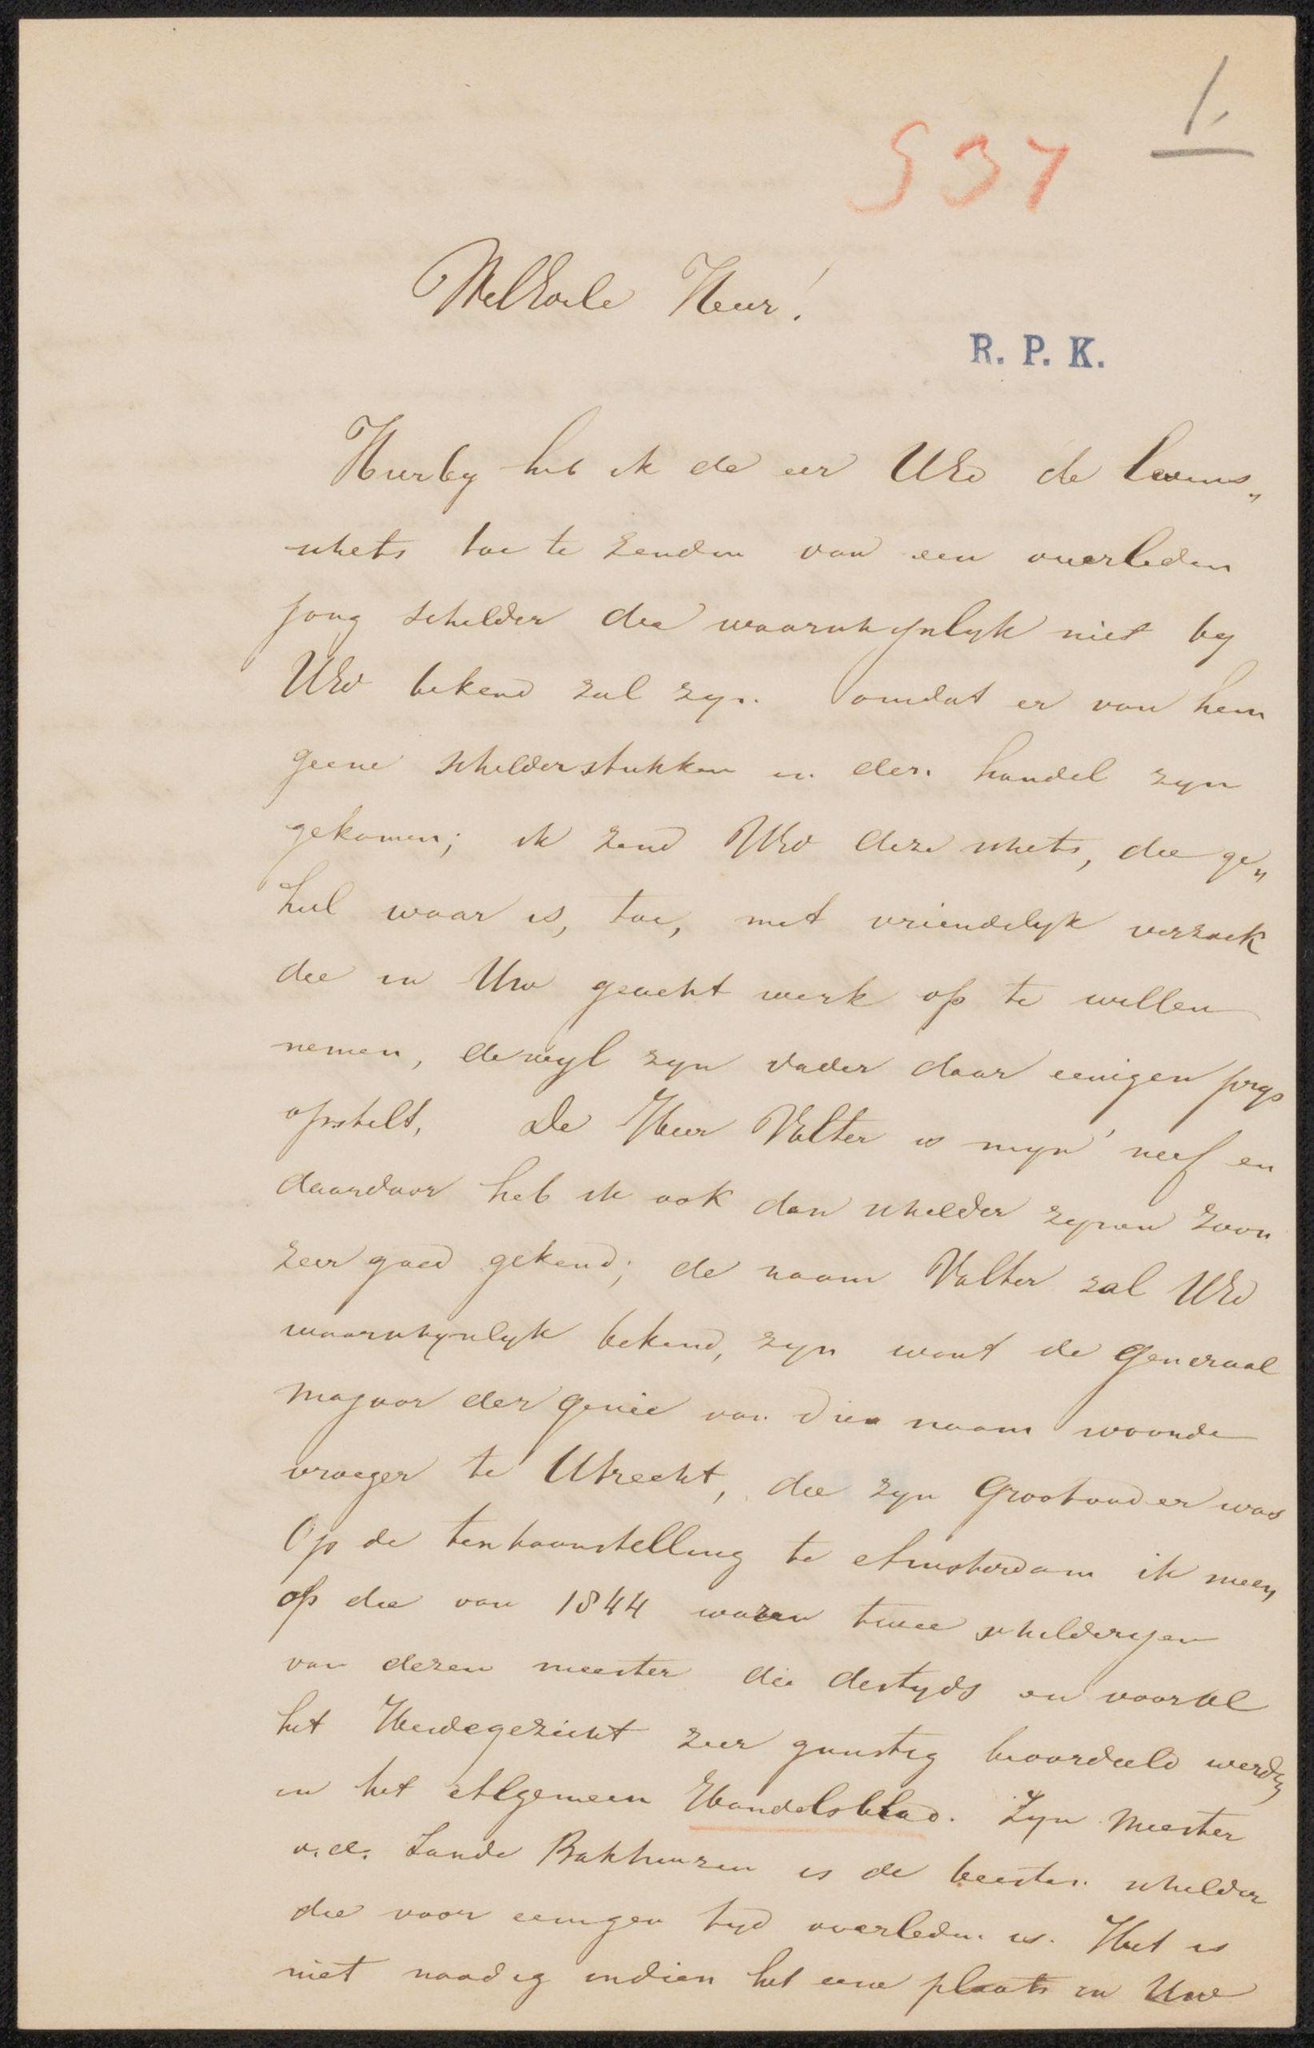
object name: letter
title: Brief aan Christiaan Kramm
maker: popko van groningen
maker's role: print maker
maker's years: 1822-1888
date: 1861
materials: ink, paper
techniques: pen, writing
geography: deventer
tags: the hague, hendrikus van de sande bakhuyzen, draughtsman, willem valter pzn, utrecht, christiaan kramm, art trade, art shop, painting (including book-illumination, miniature-painting), exhibition ~ art, money, amsterdam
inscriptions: collector's mark: Lugt 2233